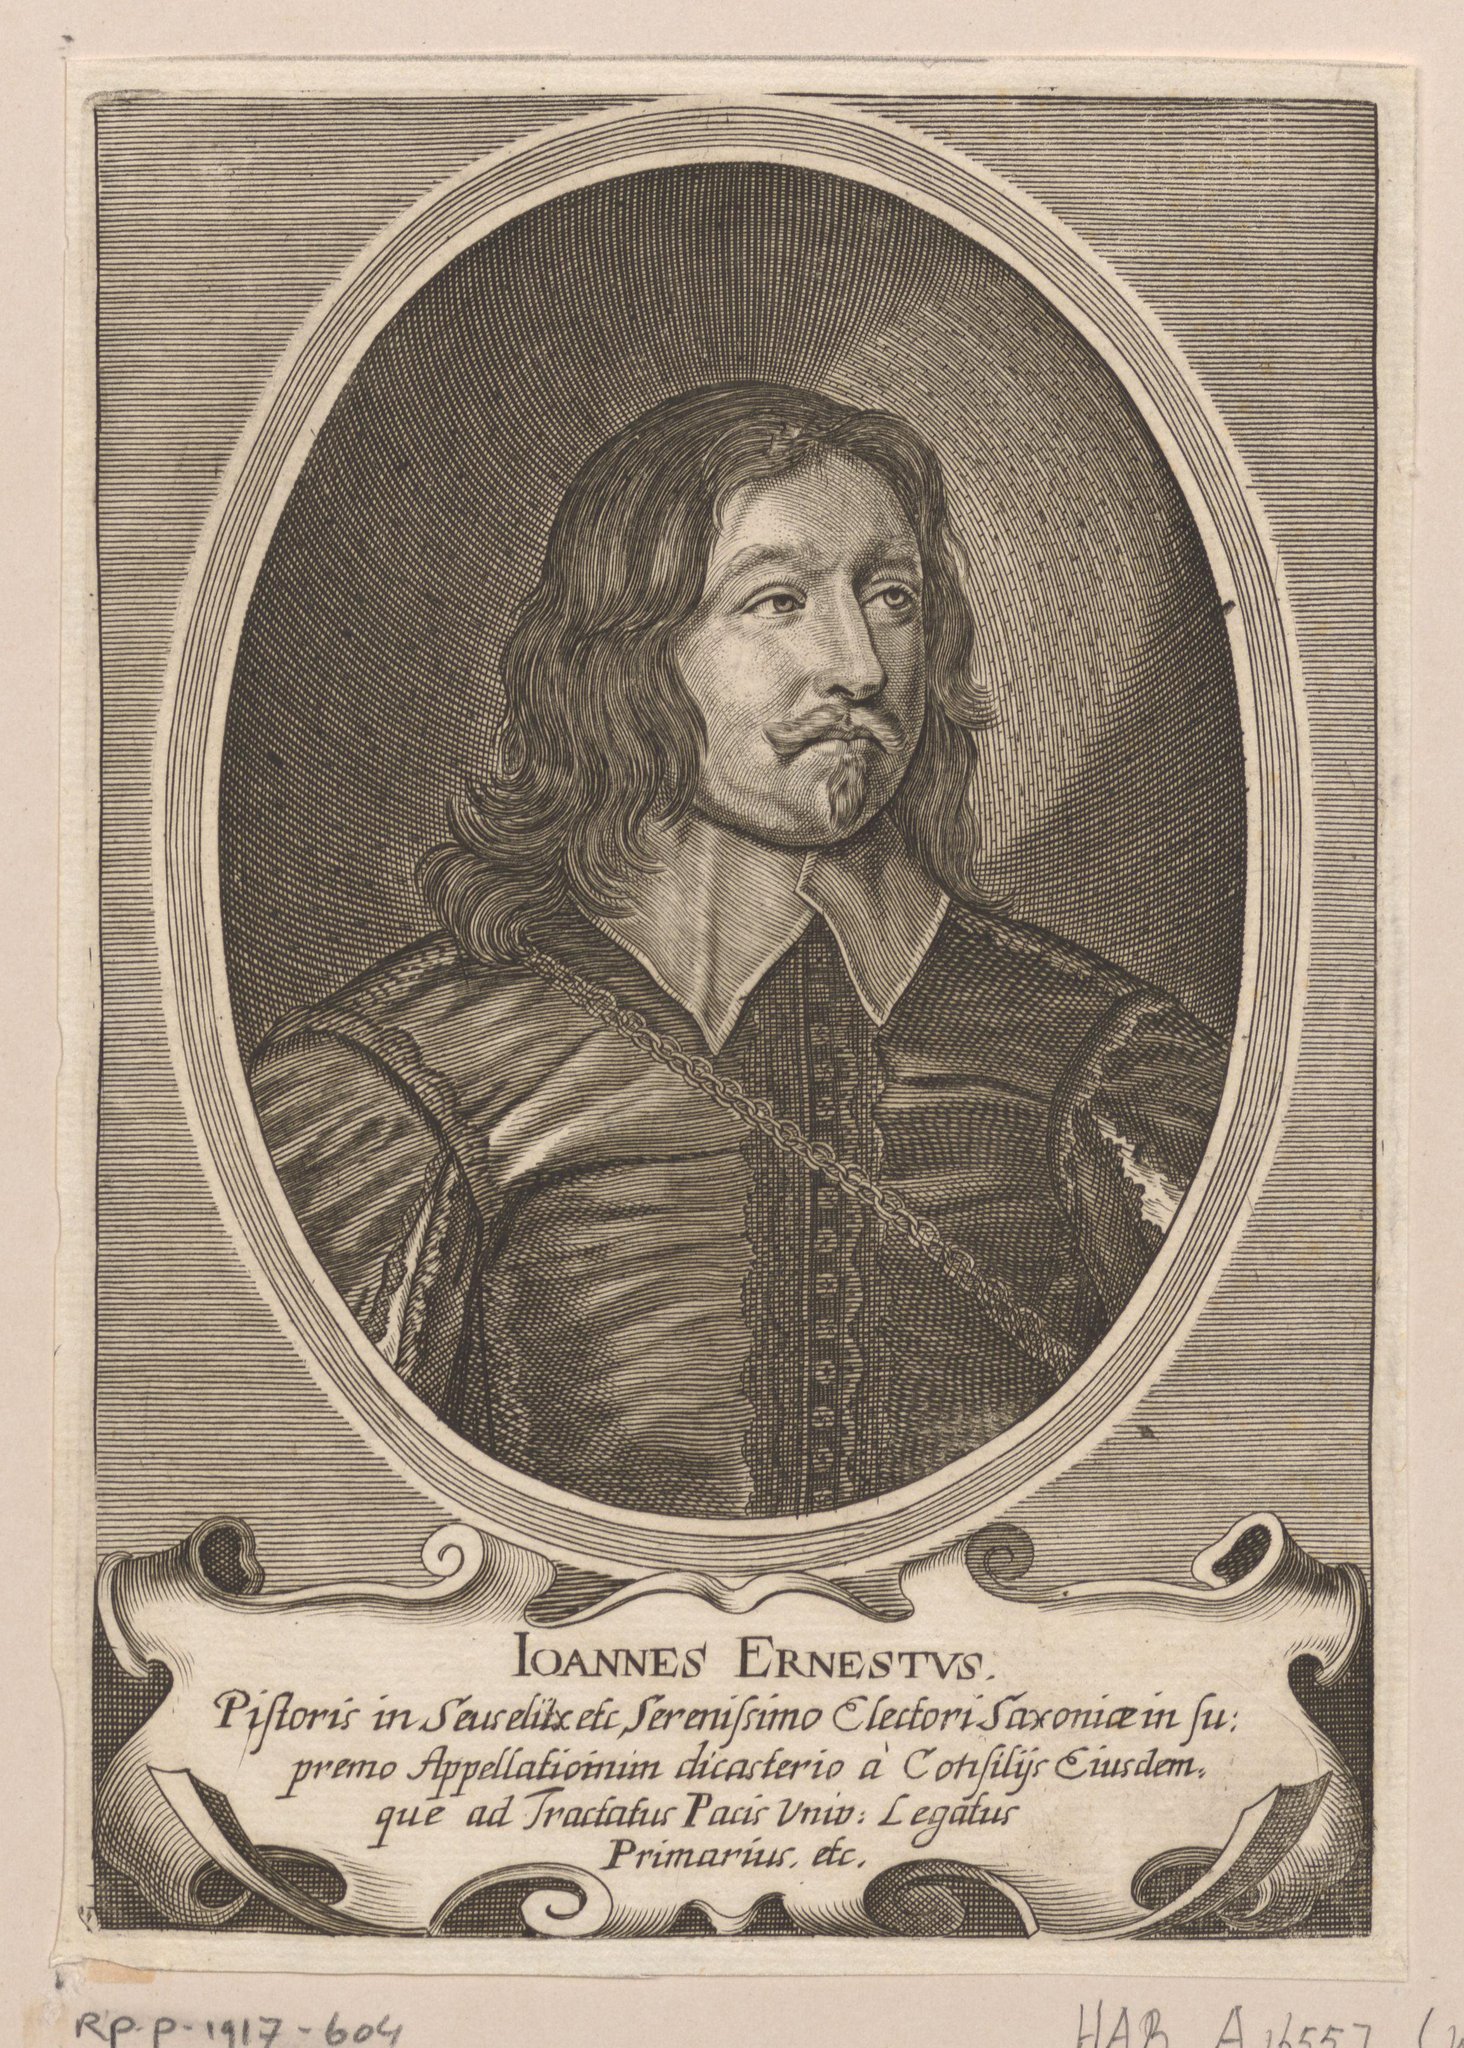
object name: print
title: Portret van Johann Ernst van Pistoris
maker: Anonymous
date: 1663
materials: paper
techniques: engraving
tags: adult man, historical persons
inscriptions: collector's mark: Lugt 2228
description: Prent mogelijk uit: Theatrum Europaeum. Frankfurt am Main: erven Matthäus Merians, 1663, dl. 6.